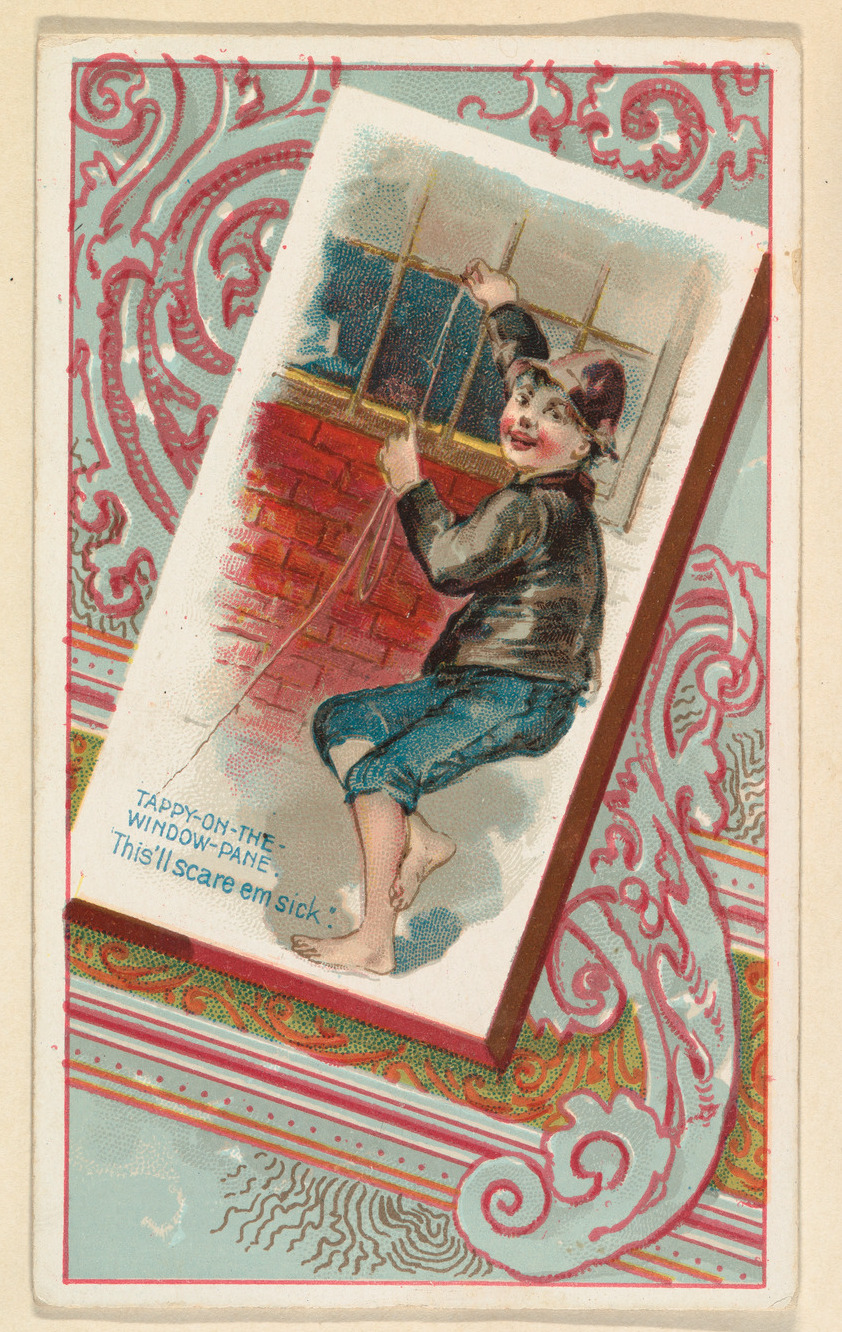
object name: print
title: Tappy-on-the-Window-Pane, "This'll scare em sick," from the Terrors of America set (N136) issued by Duke Sons & Co. to promote Honest Long Cut Tobacco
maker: w. duke, sons & co.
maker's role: publisher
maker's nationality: american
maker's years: 1870-1920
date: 1888-1889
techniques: color lithograph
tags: boys